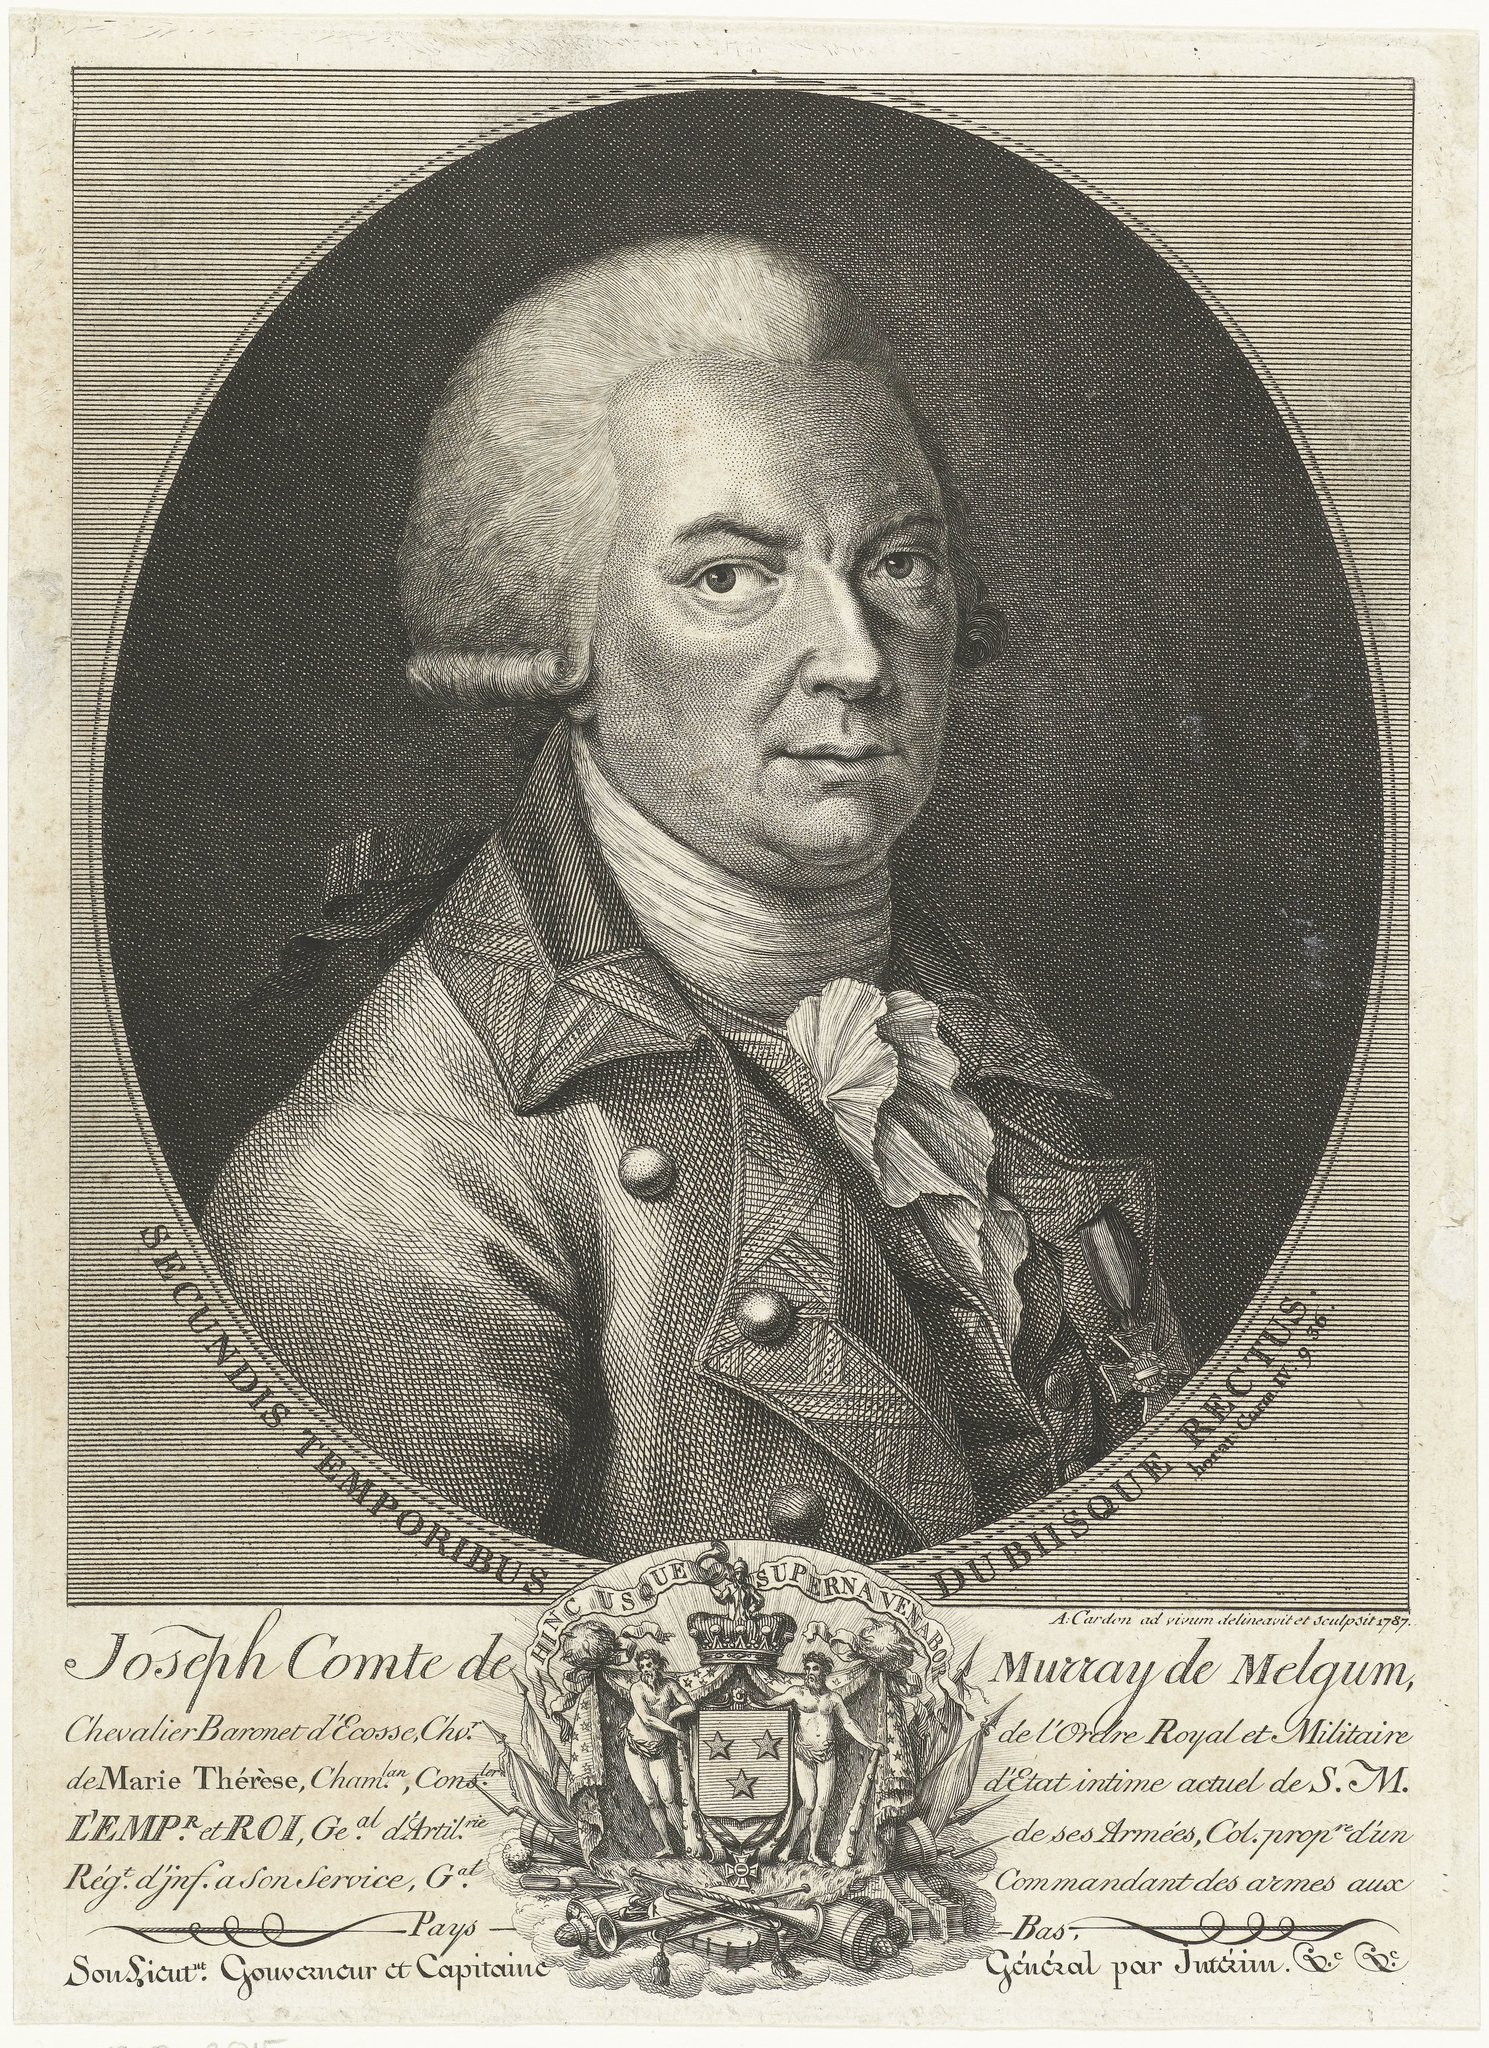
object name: print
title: Portret van Joseph graaf van Murray de Melgum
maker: antoine alexandre joseph cardon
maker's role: print maker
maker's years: 1739-1822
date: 1787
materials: paper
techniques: engraving, etching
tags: vienna, earl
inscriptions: collector's mark: Lugt 2228